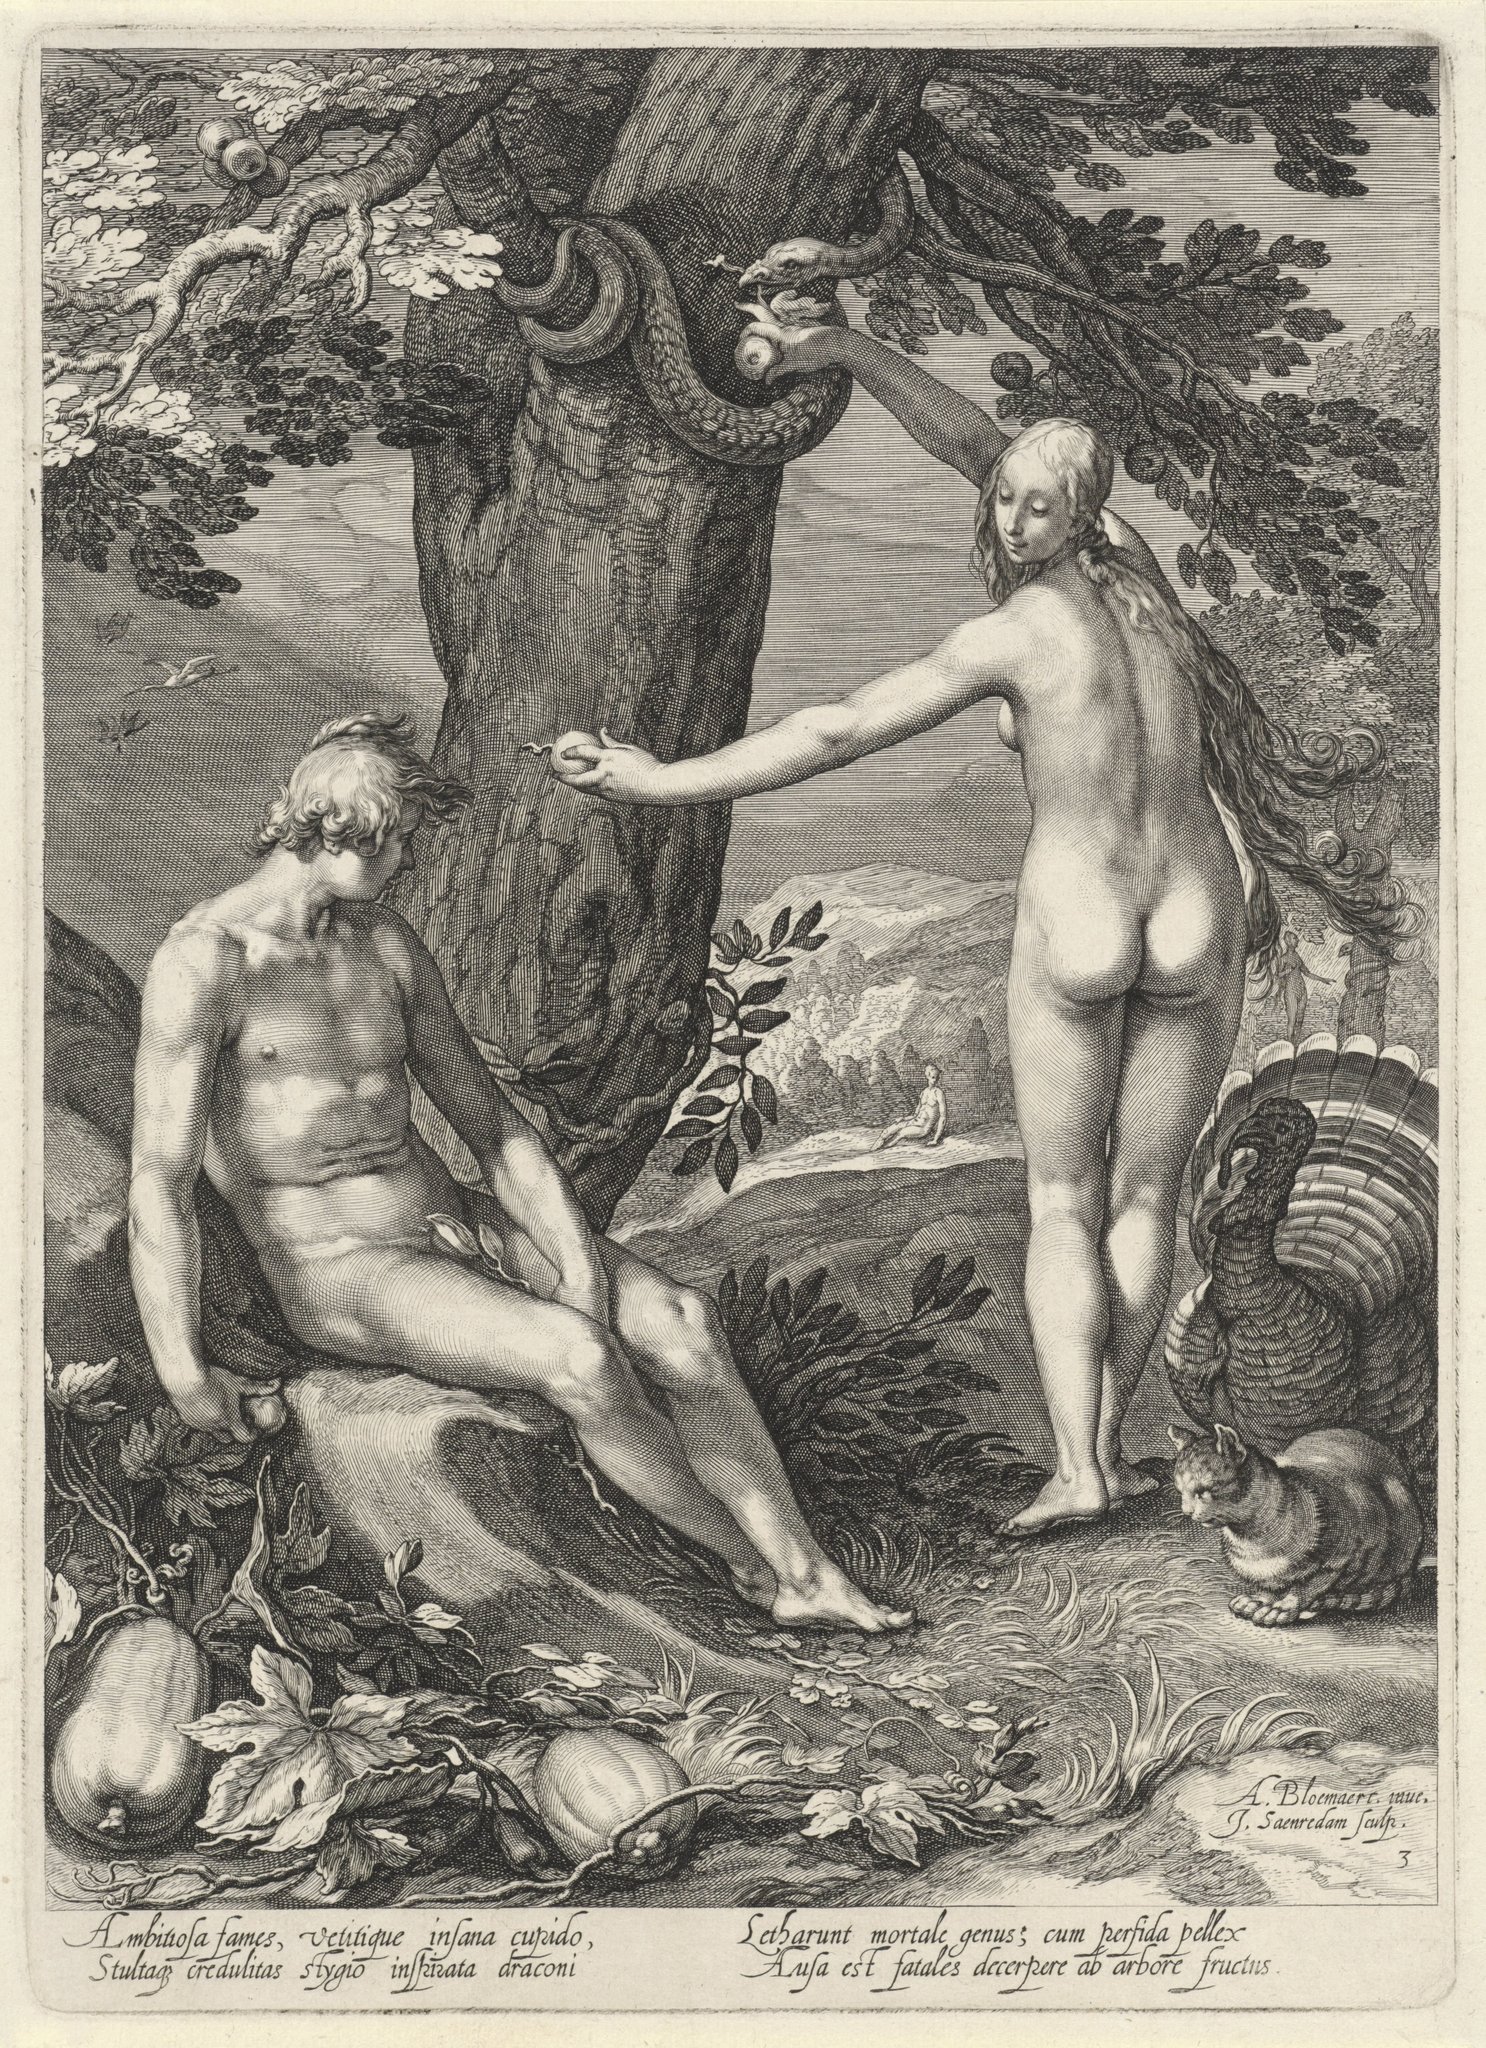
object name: print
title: Zondeval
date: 1604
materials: paper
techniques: engraving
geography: assendelft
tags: eve simultaneously offers some of the fruit to adam and takes some more from the serpent (or the tree), cat, the serpent tries to persuade eve to take some of the fruit (usually an apple), walker and runner birds: turkey, temptation and fall (scenes with both adam and eve)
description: Eva biedt Adam een appel aan van de boom der kennis van goed en kwaad. Rond de stam van de boom is een slang gekronkeld die Eva een andere appel aanreikt. Op de achtergrond wordt Eva verleid door de slang.